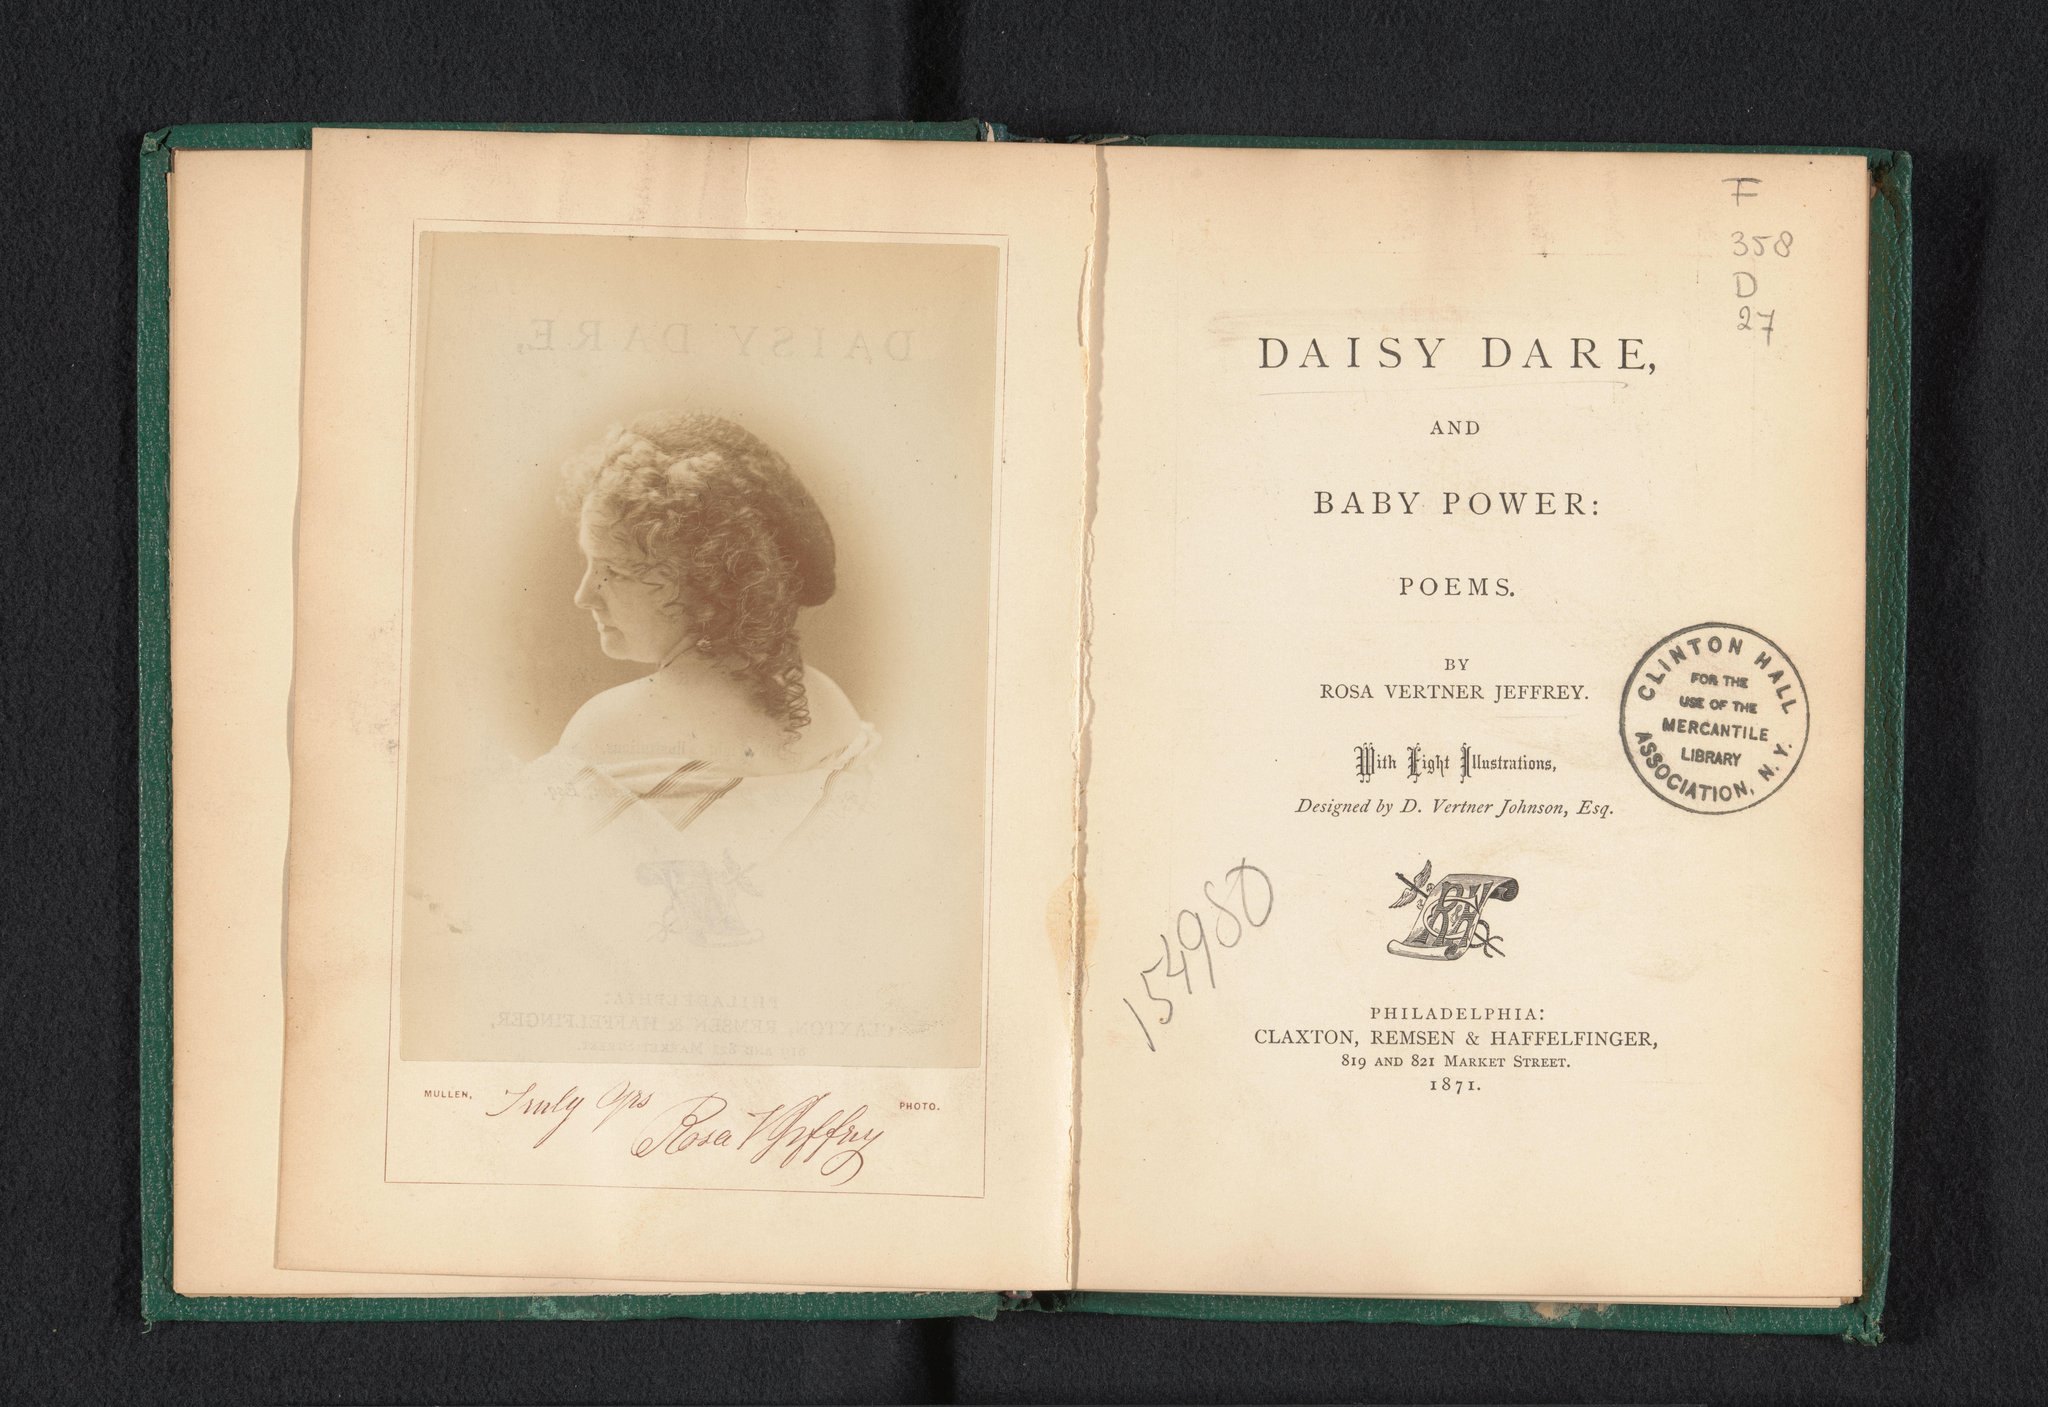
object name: book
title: Daisy dare, and baby power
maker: rosa vertner jeffrey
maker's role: dichter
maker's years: 1828-1894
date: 1871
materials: cardboard, linen, paper, photographic support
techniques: albumen print, printing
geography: philadelphia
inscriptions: inscription: ‘Clinton Hall for the use of the mercantile library association N.Y.’